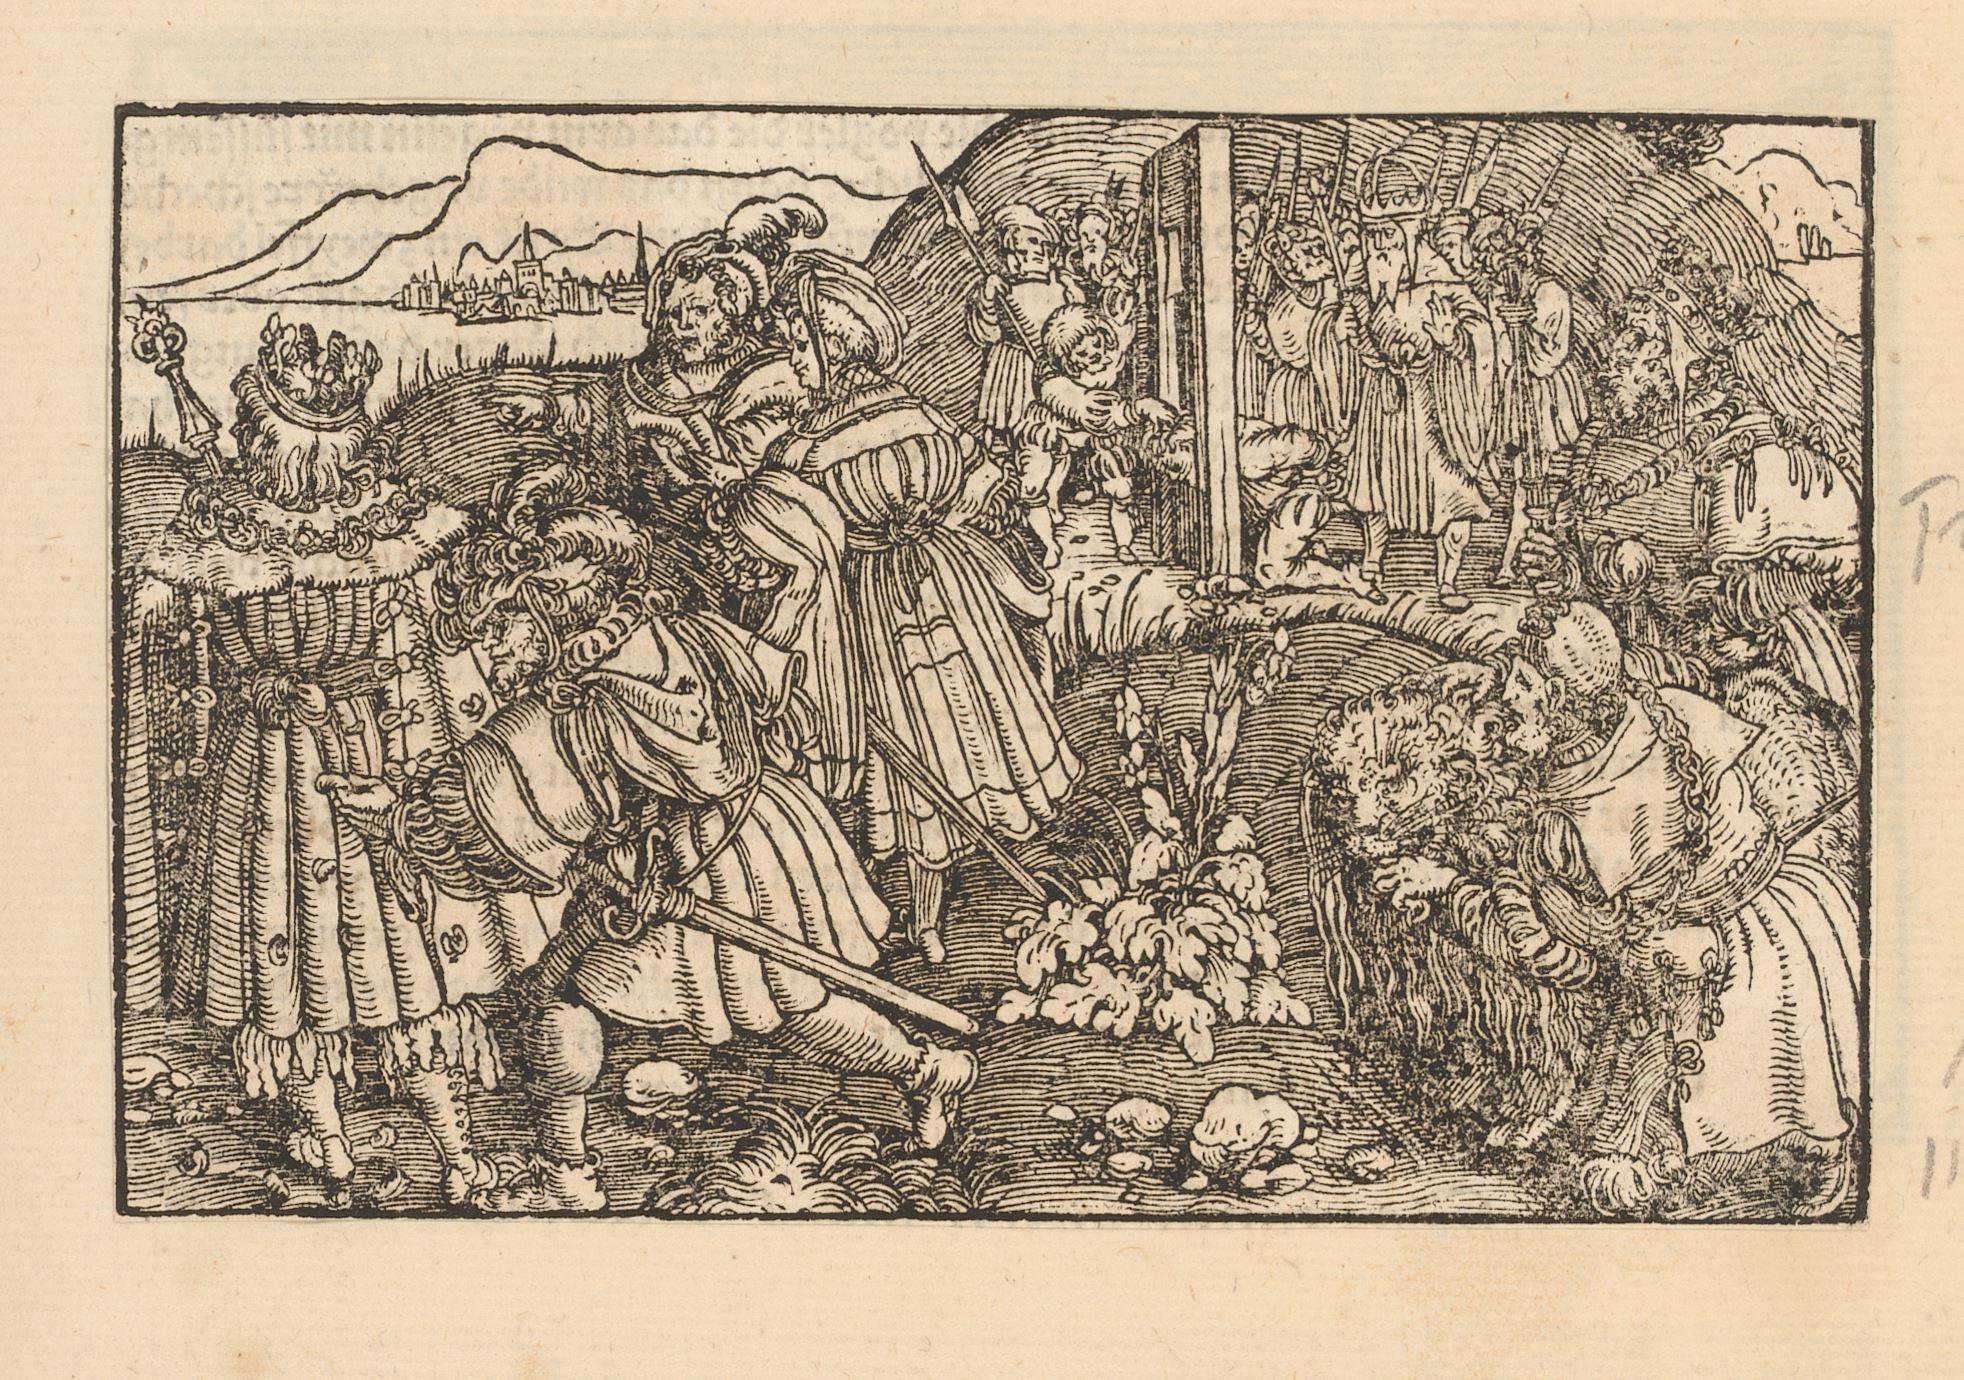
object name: book illustration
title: Diefstal, onthoofding en een aanval door een leeuw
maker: Anonymous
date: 1514-1532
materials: paper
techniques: letterpress printing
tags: violent death by throwing to the wild animals, violent death ~ beheading by guillotine, pickpocket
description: Deze prent is gebruikt in: Petrarca, Francesco. Von der Artzney bayder Glück, des guten und widerwertigen: unnd weß sich ain yeder inn Gelück und Unglück halten sol (...). Augsburg: Heinrich Steiner, 1532. Deze uitgave is ook bekend onder de titel 'Trostspiegel in Glück und Unglück'.